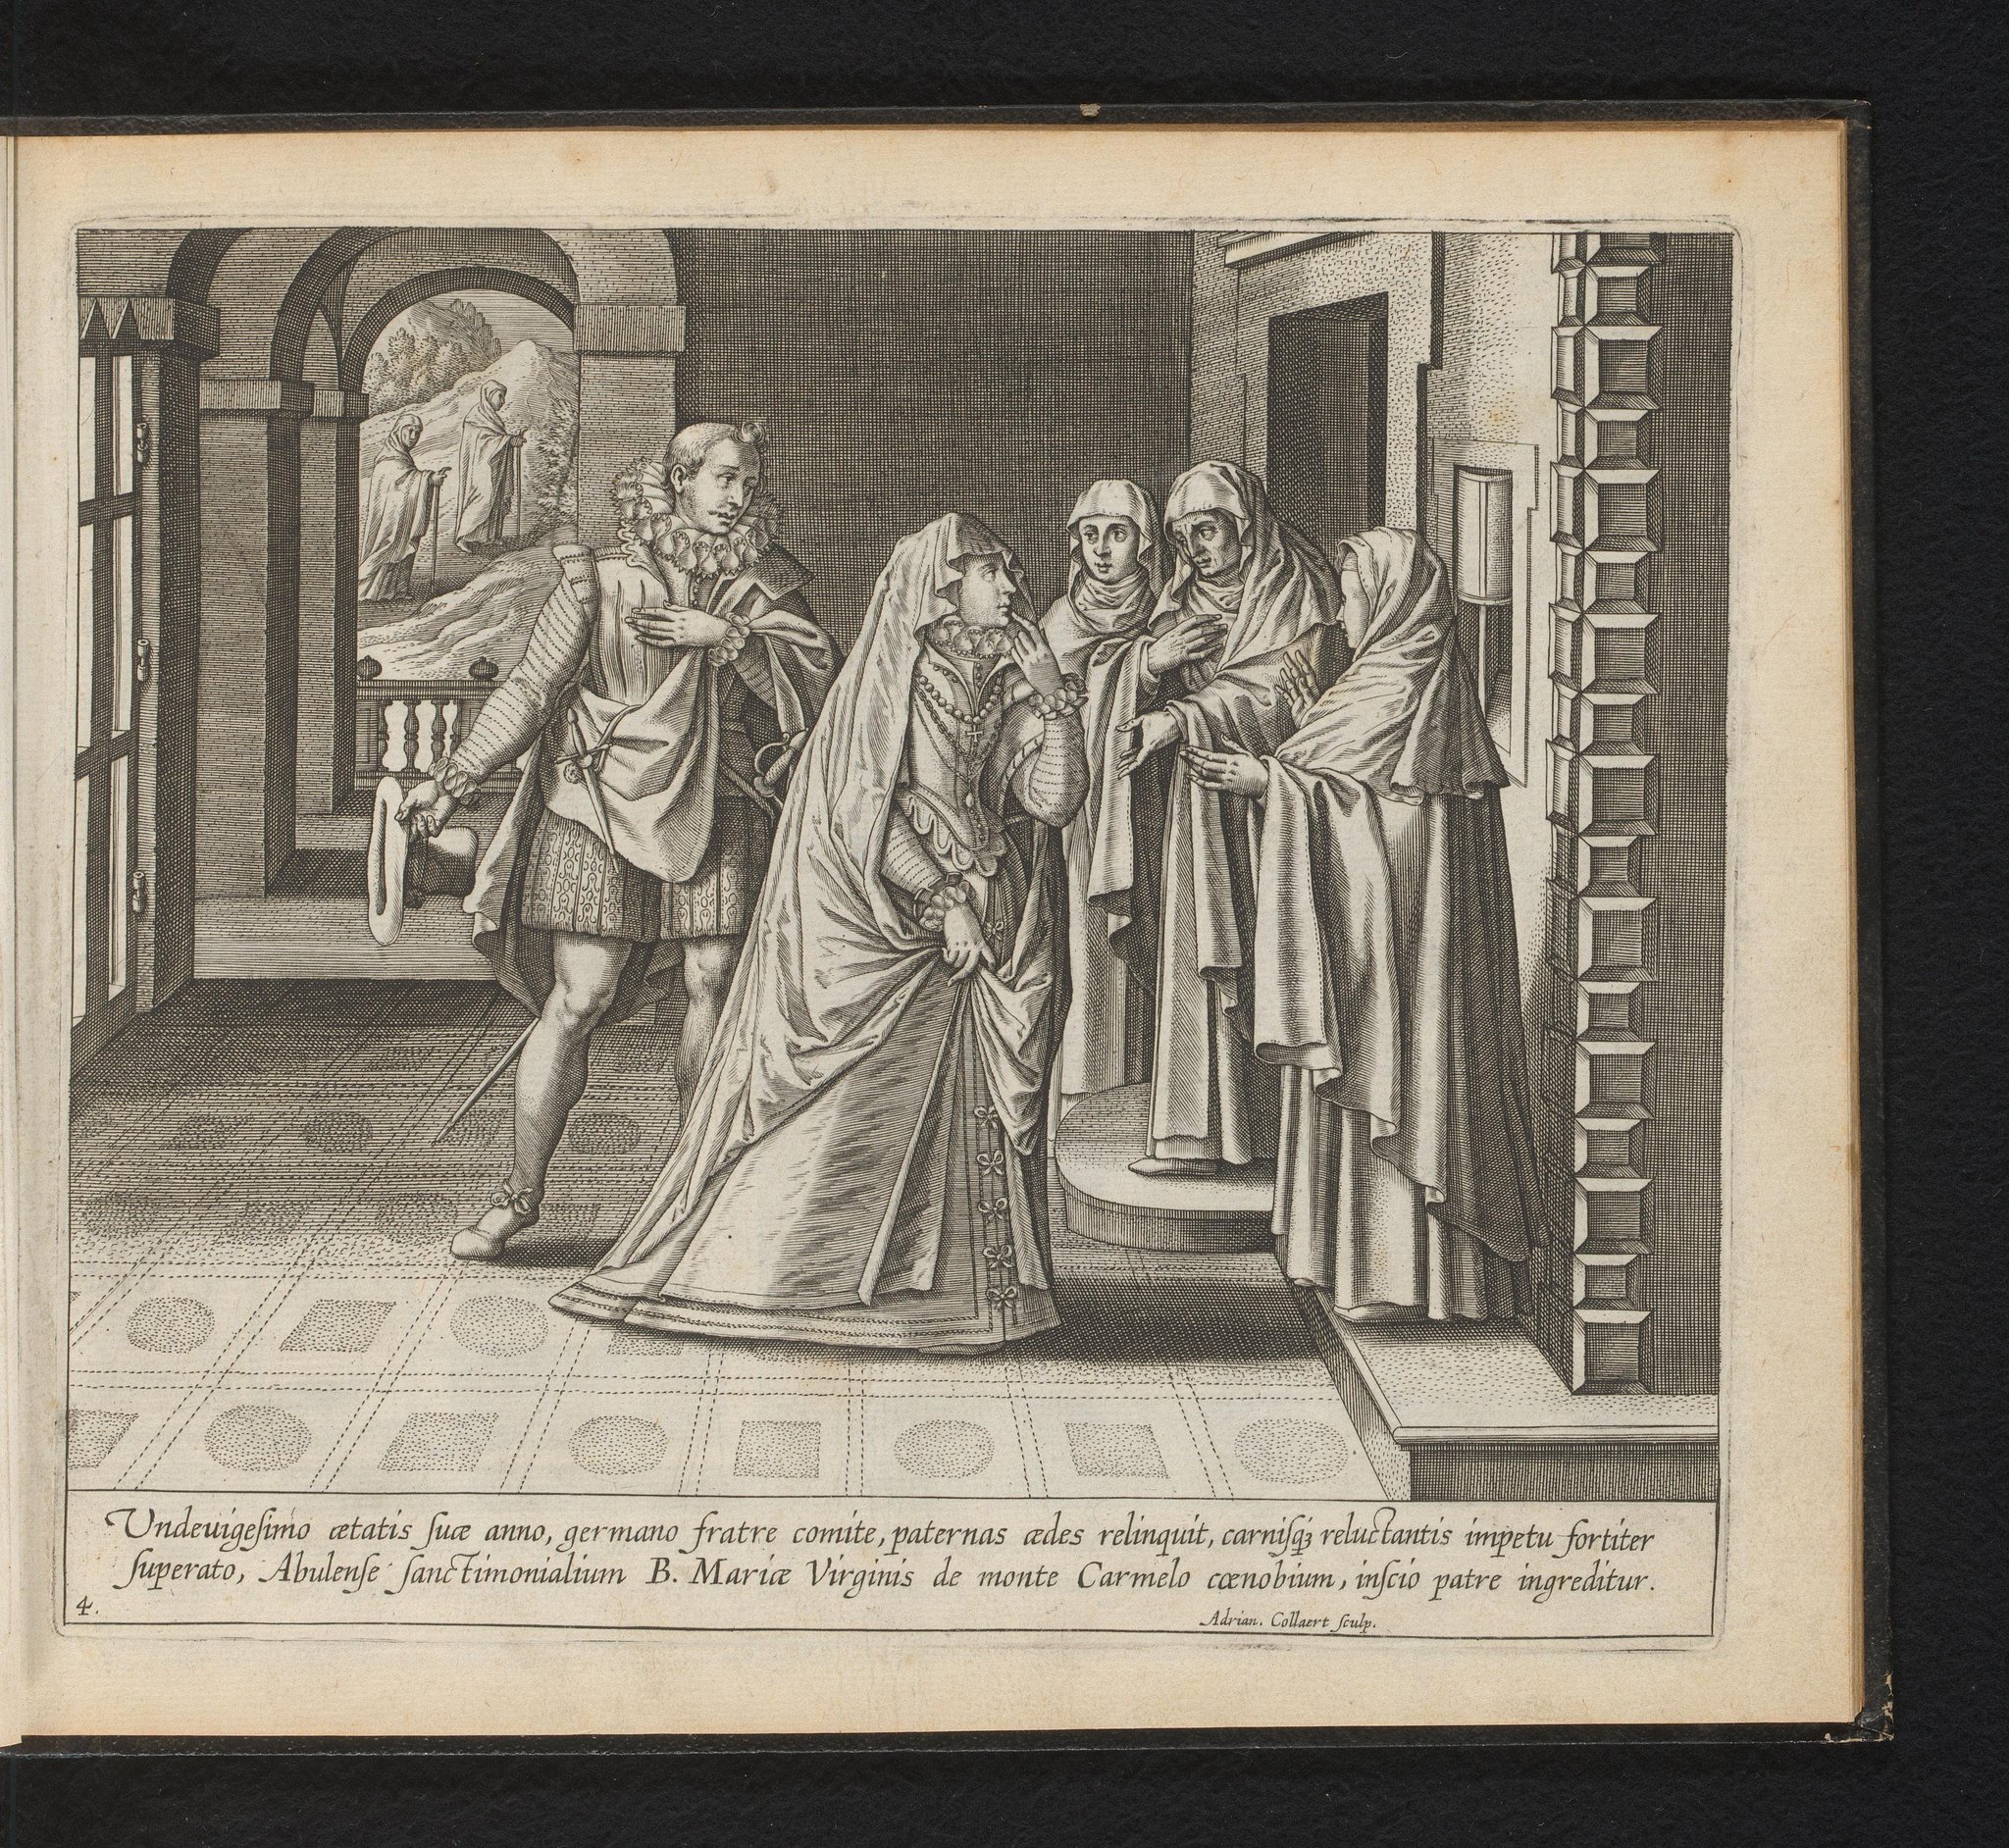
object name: print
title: De 19-jarige Teresa, vergezeld van haar broer,treedt het klooster van de H. Maagd van de berg Carmel binnen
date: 1613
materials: paper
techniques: engraving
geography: antwerp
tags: personal devotion of st. theresa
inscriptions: number: ‘4’, caption: ‘Undevigesimo aetatis suae anno...patre ingreditur’, signature: ‘Adrian Collaert sculp.’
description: Prent in album 'Vita B. Virginis Teresiae A. Jesu ordinis carmelitarum excalceatorum piae restauratricis..., 1613.